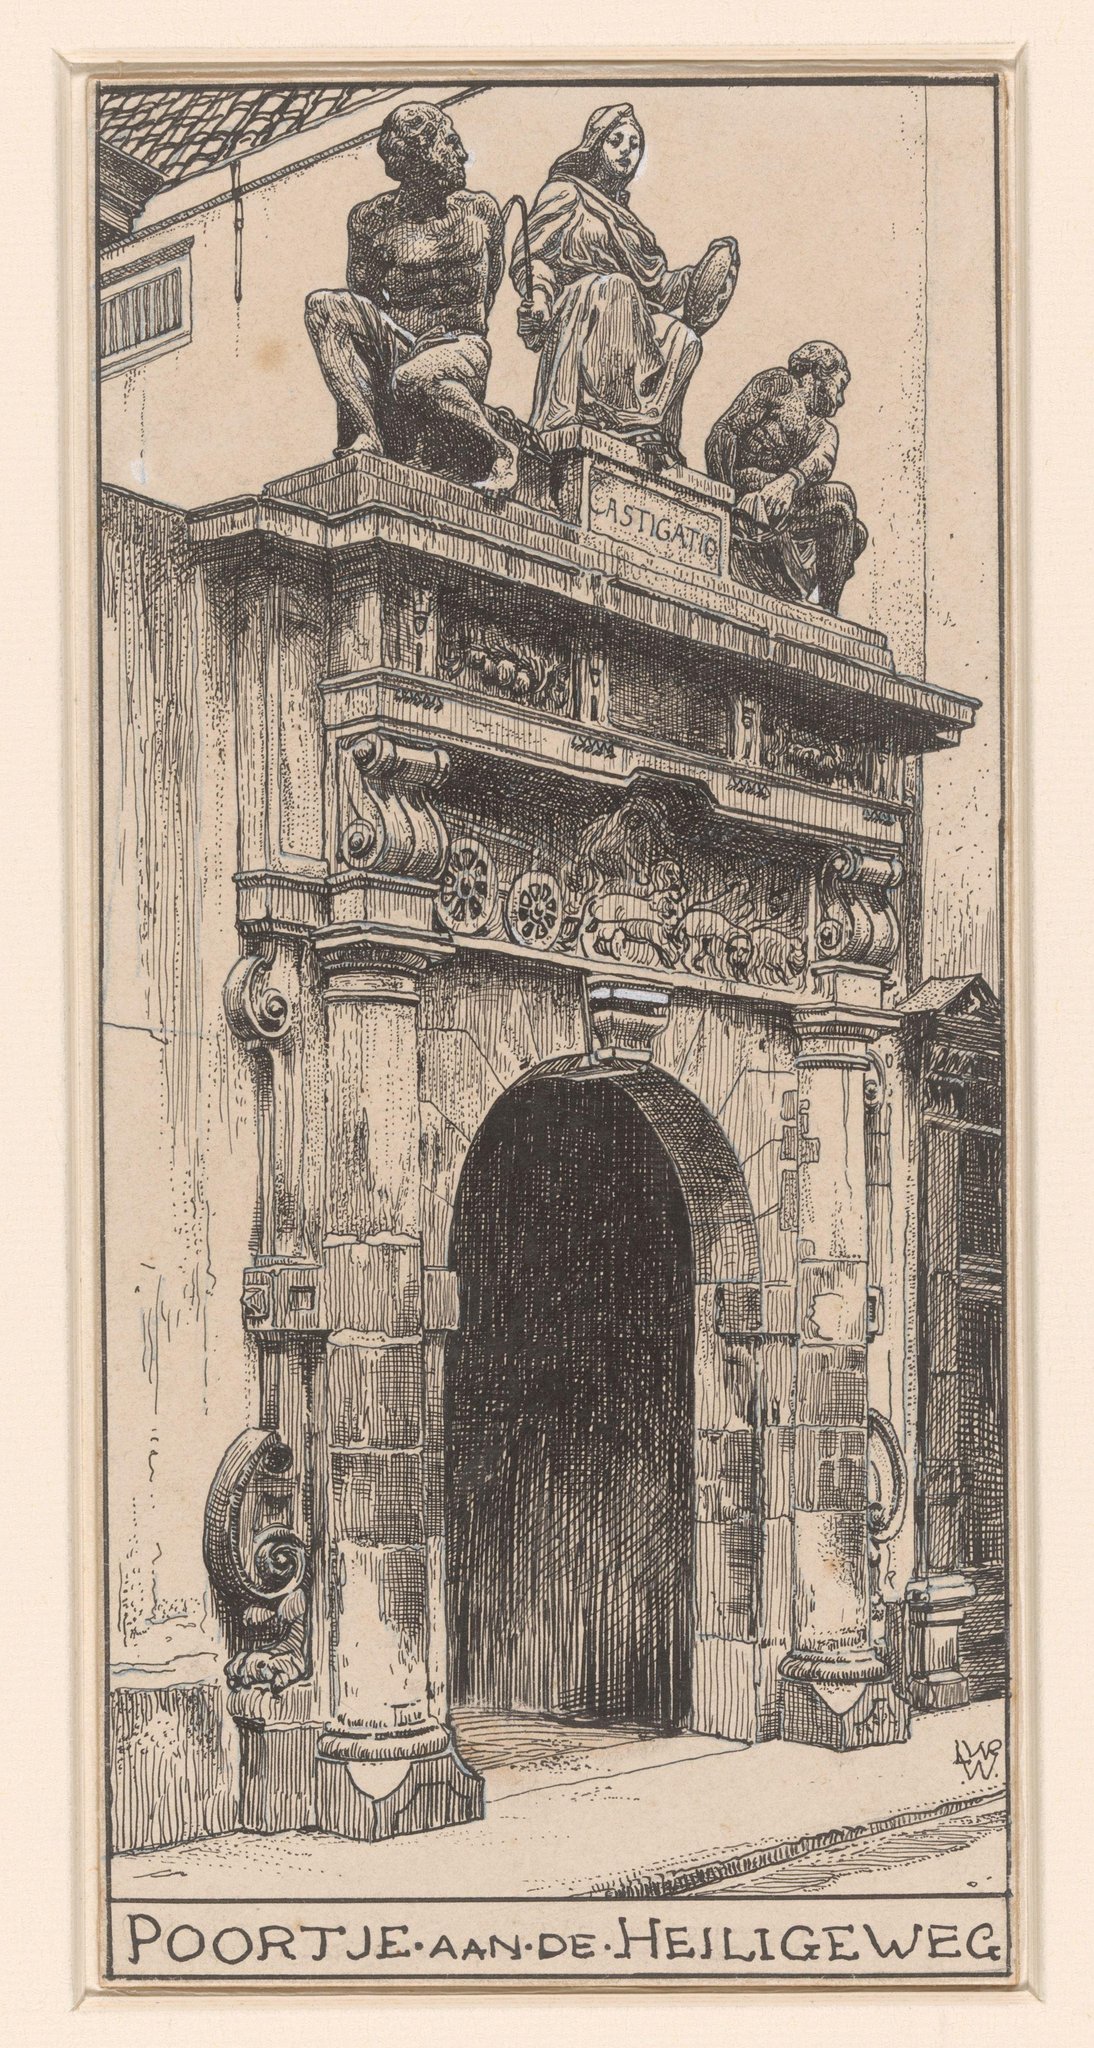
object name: drawing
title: Poortje van het voormalige Mannentuchthuis aan de Heiligeweg te Amsterdam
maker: willem wenckebach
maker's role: designer, draughtsman, painter, print maker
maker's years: 1860-1937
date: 1870-1926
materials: cardboard, paint, ink, pencil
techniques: pen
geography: amsterdam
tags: monumental door, porch, 'aediculum'